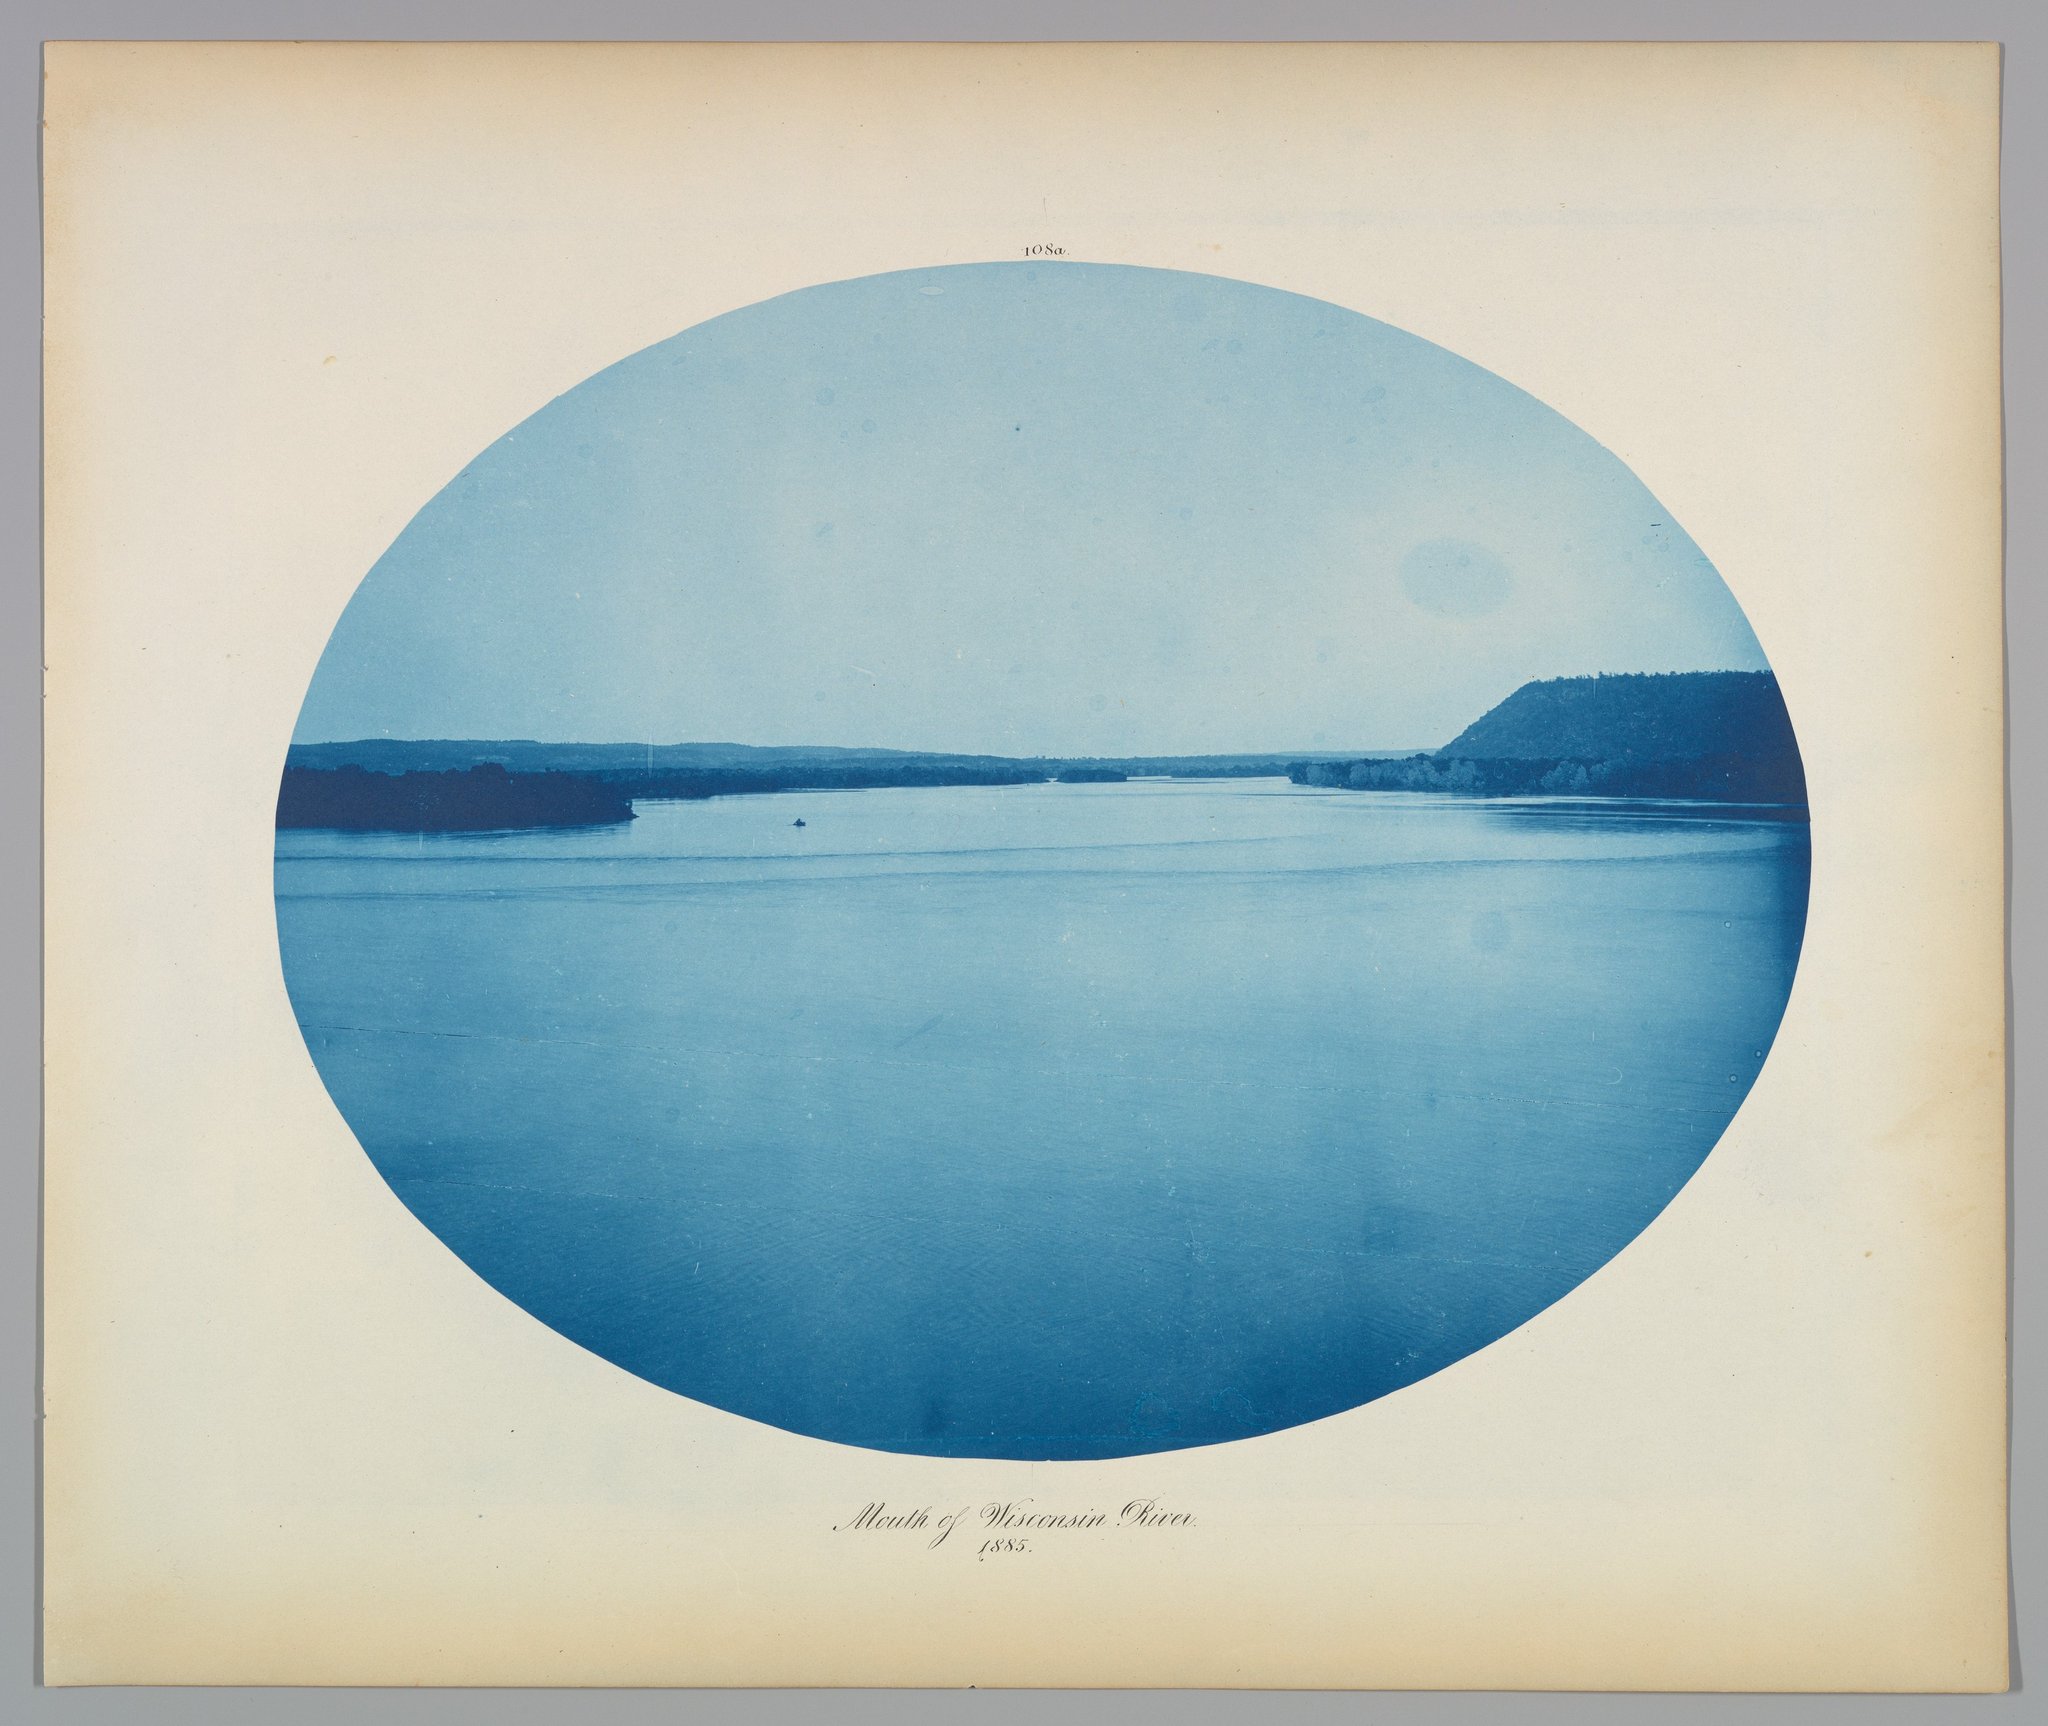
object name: photograph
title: Mouth of Wisconsin River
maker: henry p. bosse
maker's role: artist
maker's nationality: american, born germany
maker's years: 1844-1893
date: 1885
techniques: cyanotype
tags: rivers,landscapes